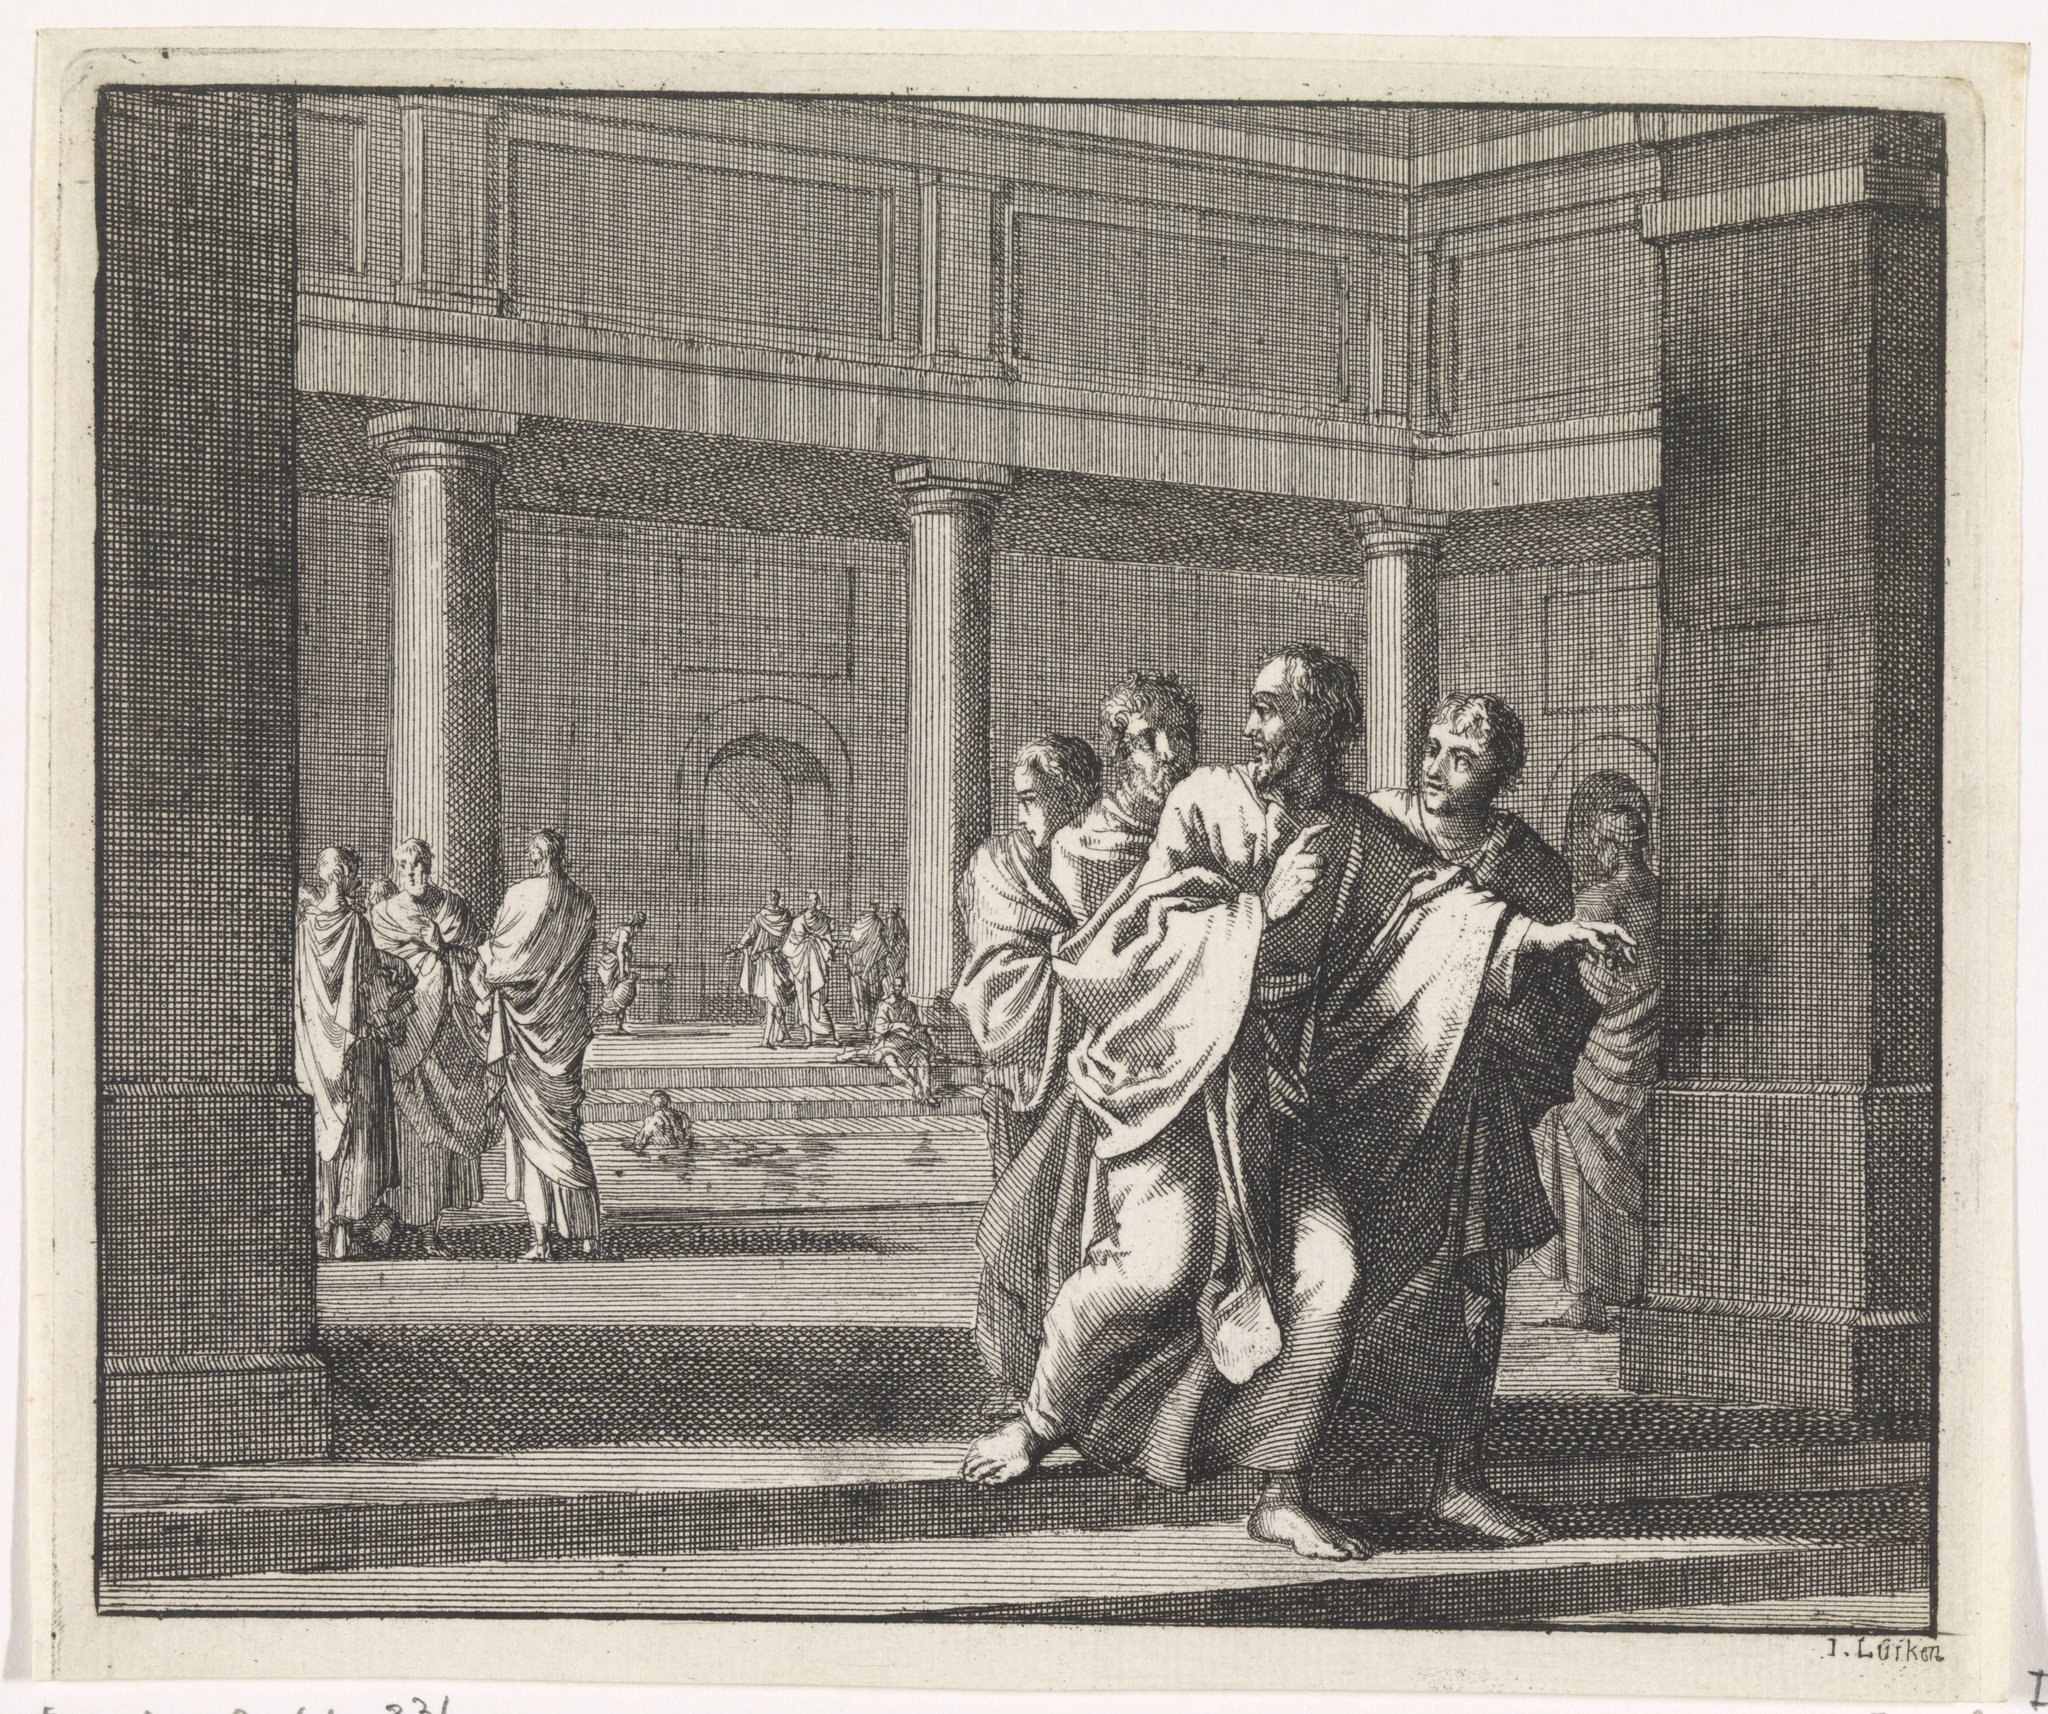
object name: print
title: Johannes en de ketter Cerinthus in het badhuis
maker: jan luyken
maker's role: draughtsman, print maker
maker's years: 1649-1712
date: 1701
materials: paper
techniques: etching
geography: amsterdam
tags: the early christian churches, e.g. armenians, copts, syrians, steambath, public baths, flight, running away; pursuing, life and acts of john the evangelist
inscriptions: collector's mark: Lugt 2228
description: Proefdruk van een boekillustratie Arnold, Godfried. Waare afbeelding der eerste christenen. Amsterdam: Jacobus van Hardenberg, Barent Visscher en Jacobus van Nieuweveen, 1700, dl. 2.